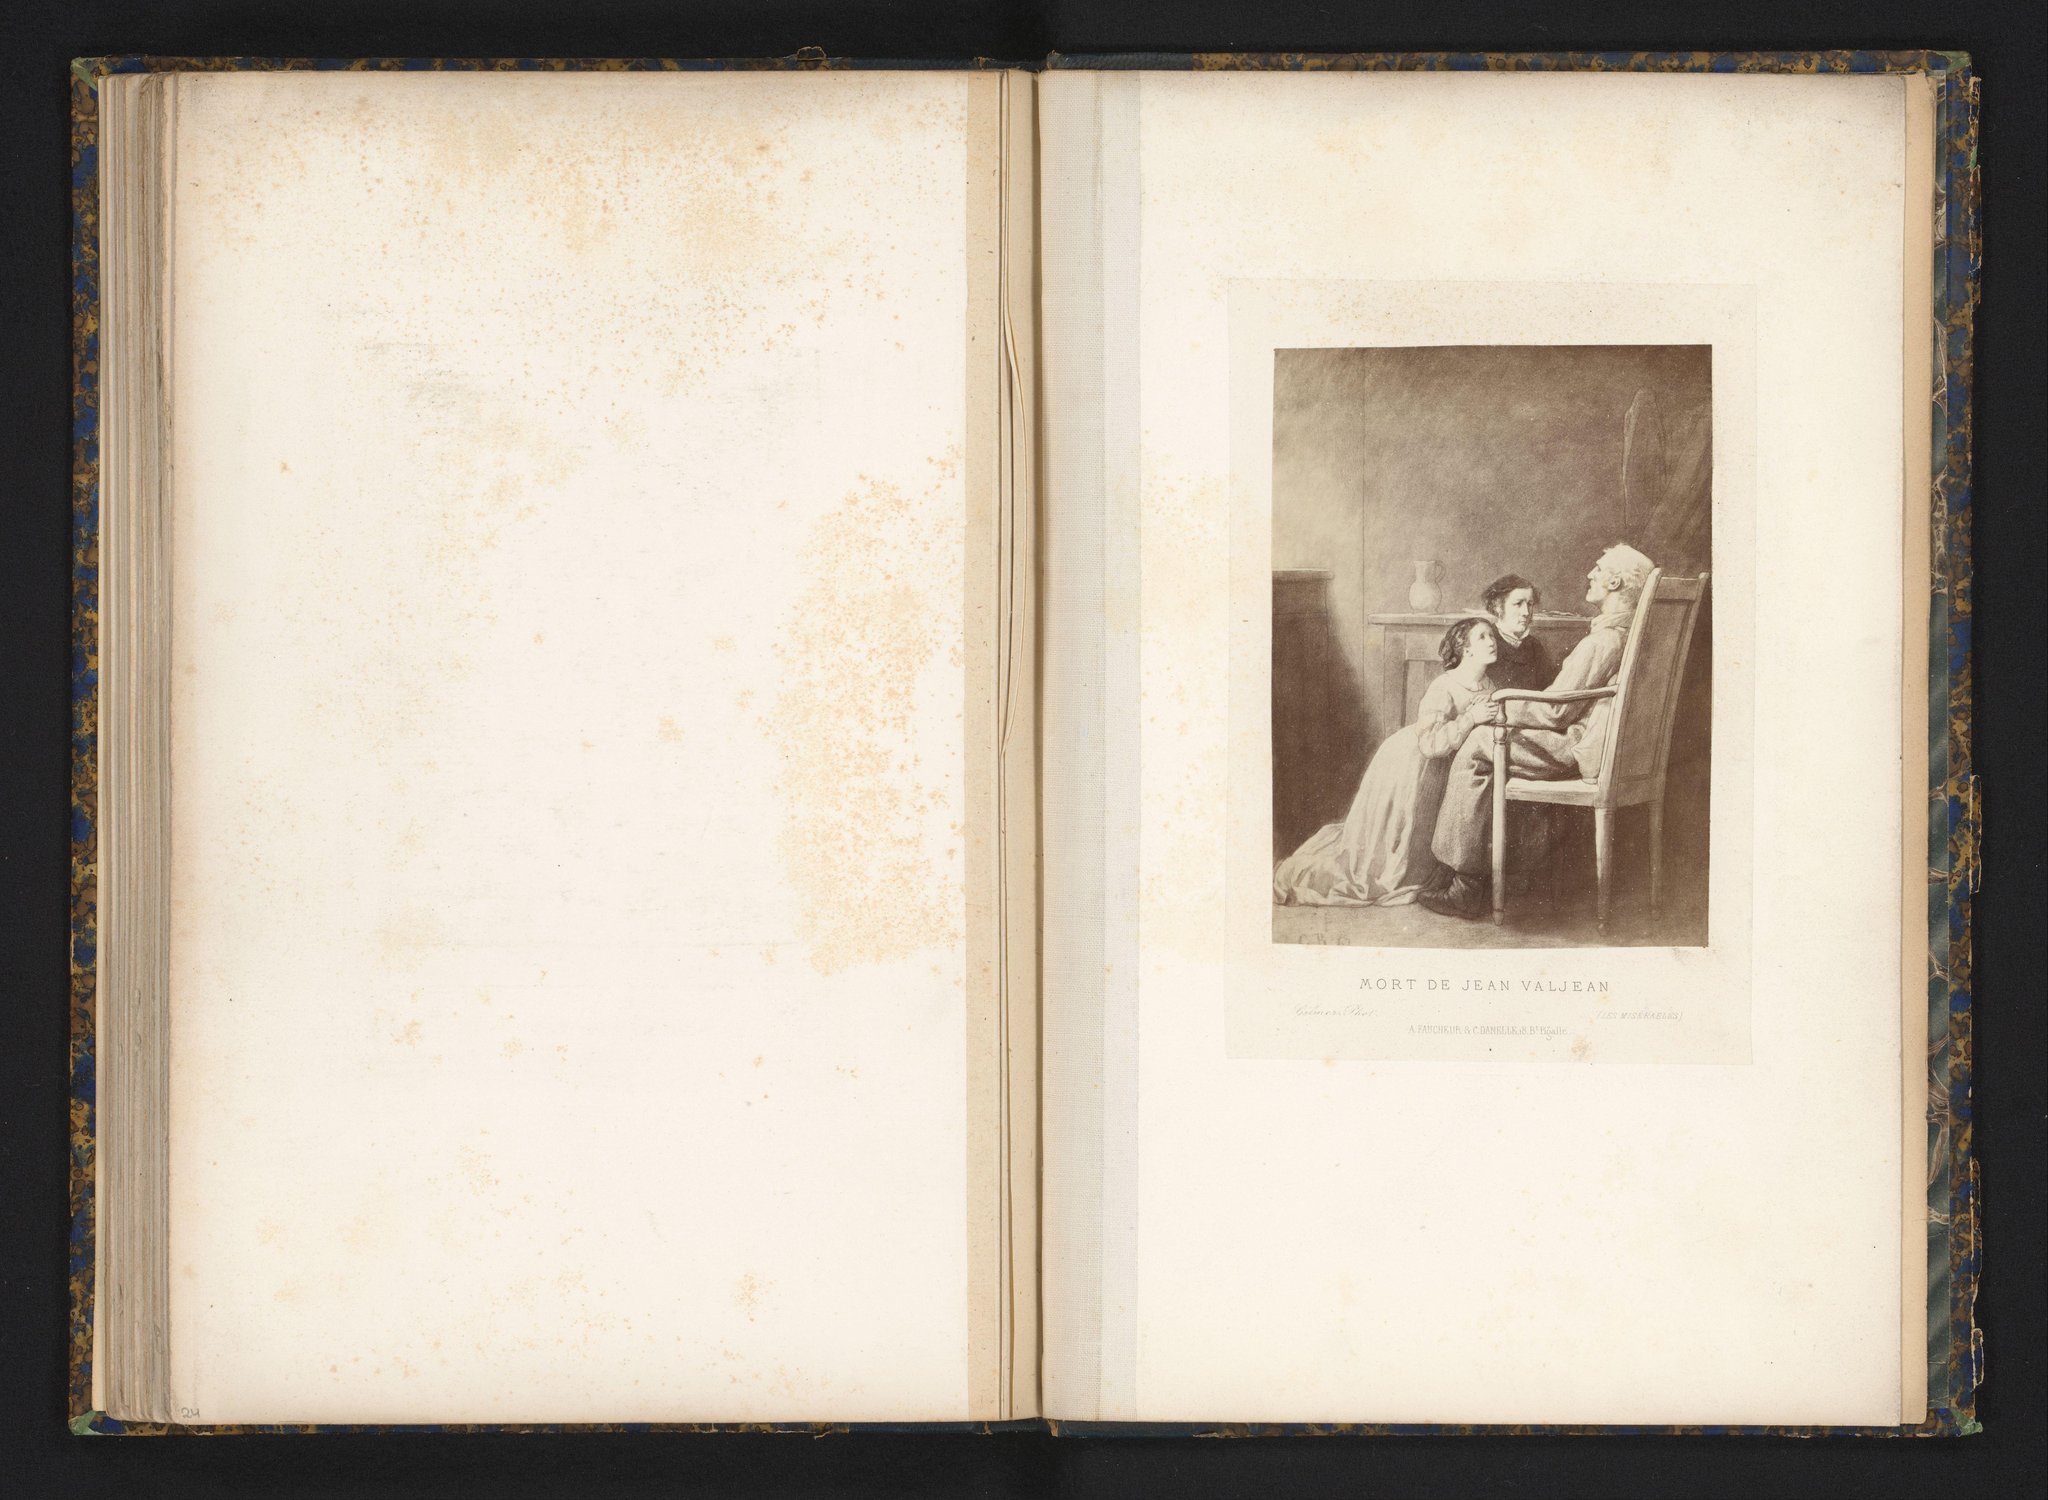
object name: reproduction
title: Mort de Jean Valjean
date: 1862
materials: photographic support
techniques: albumen print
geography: paris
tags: literary characters and objects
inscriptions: inscription: ‘(LES MISÉRABLES)’, address: ‘A. FAUCHEUR & C. DANELLE, 18, Bt. Pigalle.’